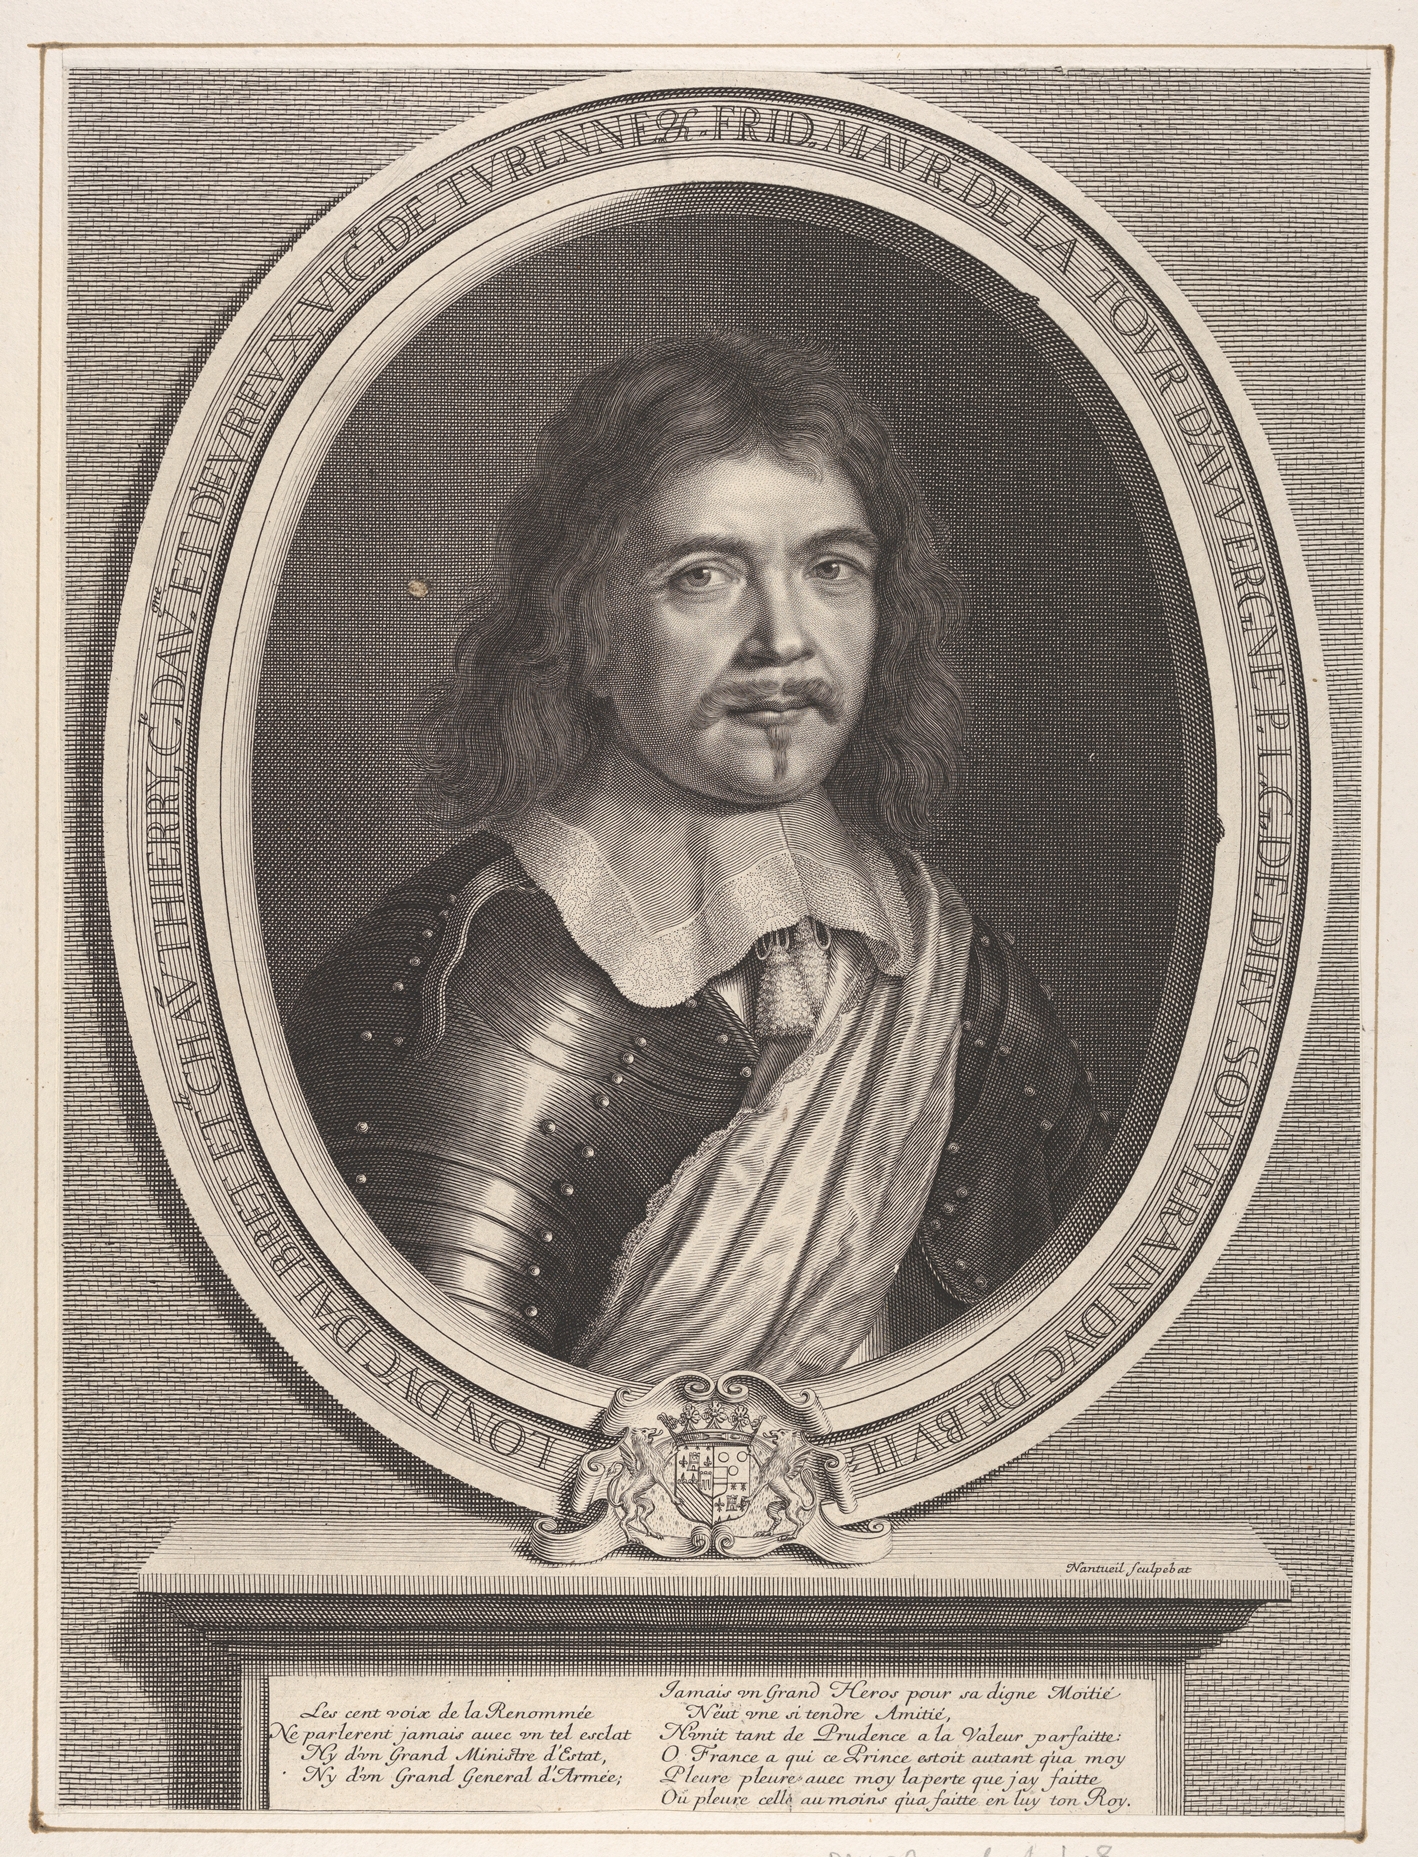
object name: print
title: Frédéric-Maurice, Duc de Bouillon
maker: robert nanteuil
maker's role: artist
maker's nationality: french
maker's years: 1623-1678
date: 1655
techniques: engraving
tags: men,portraits,coat of arms